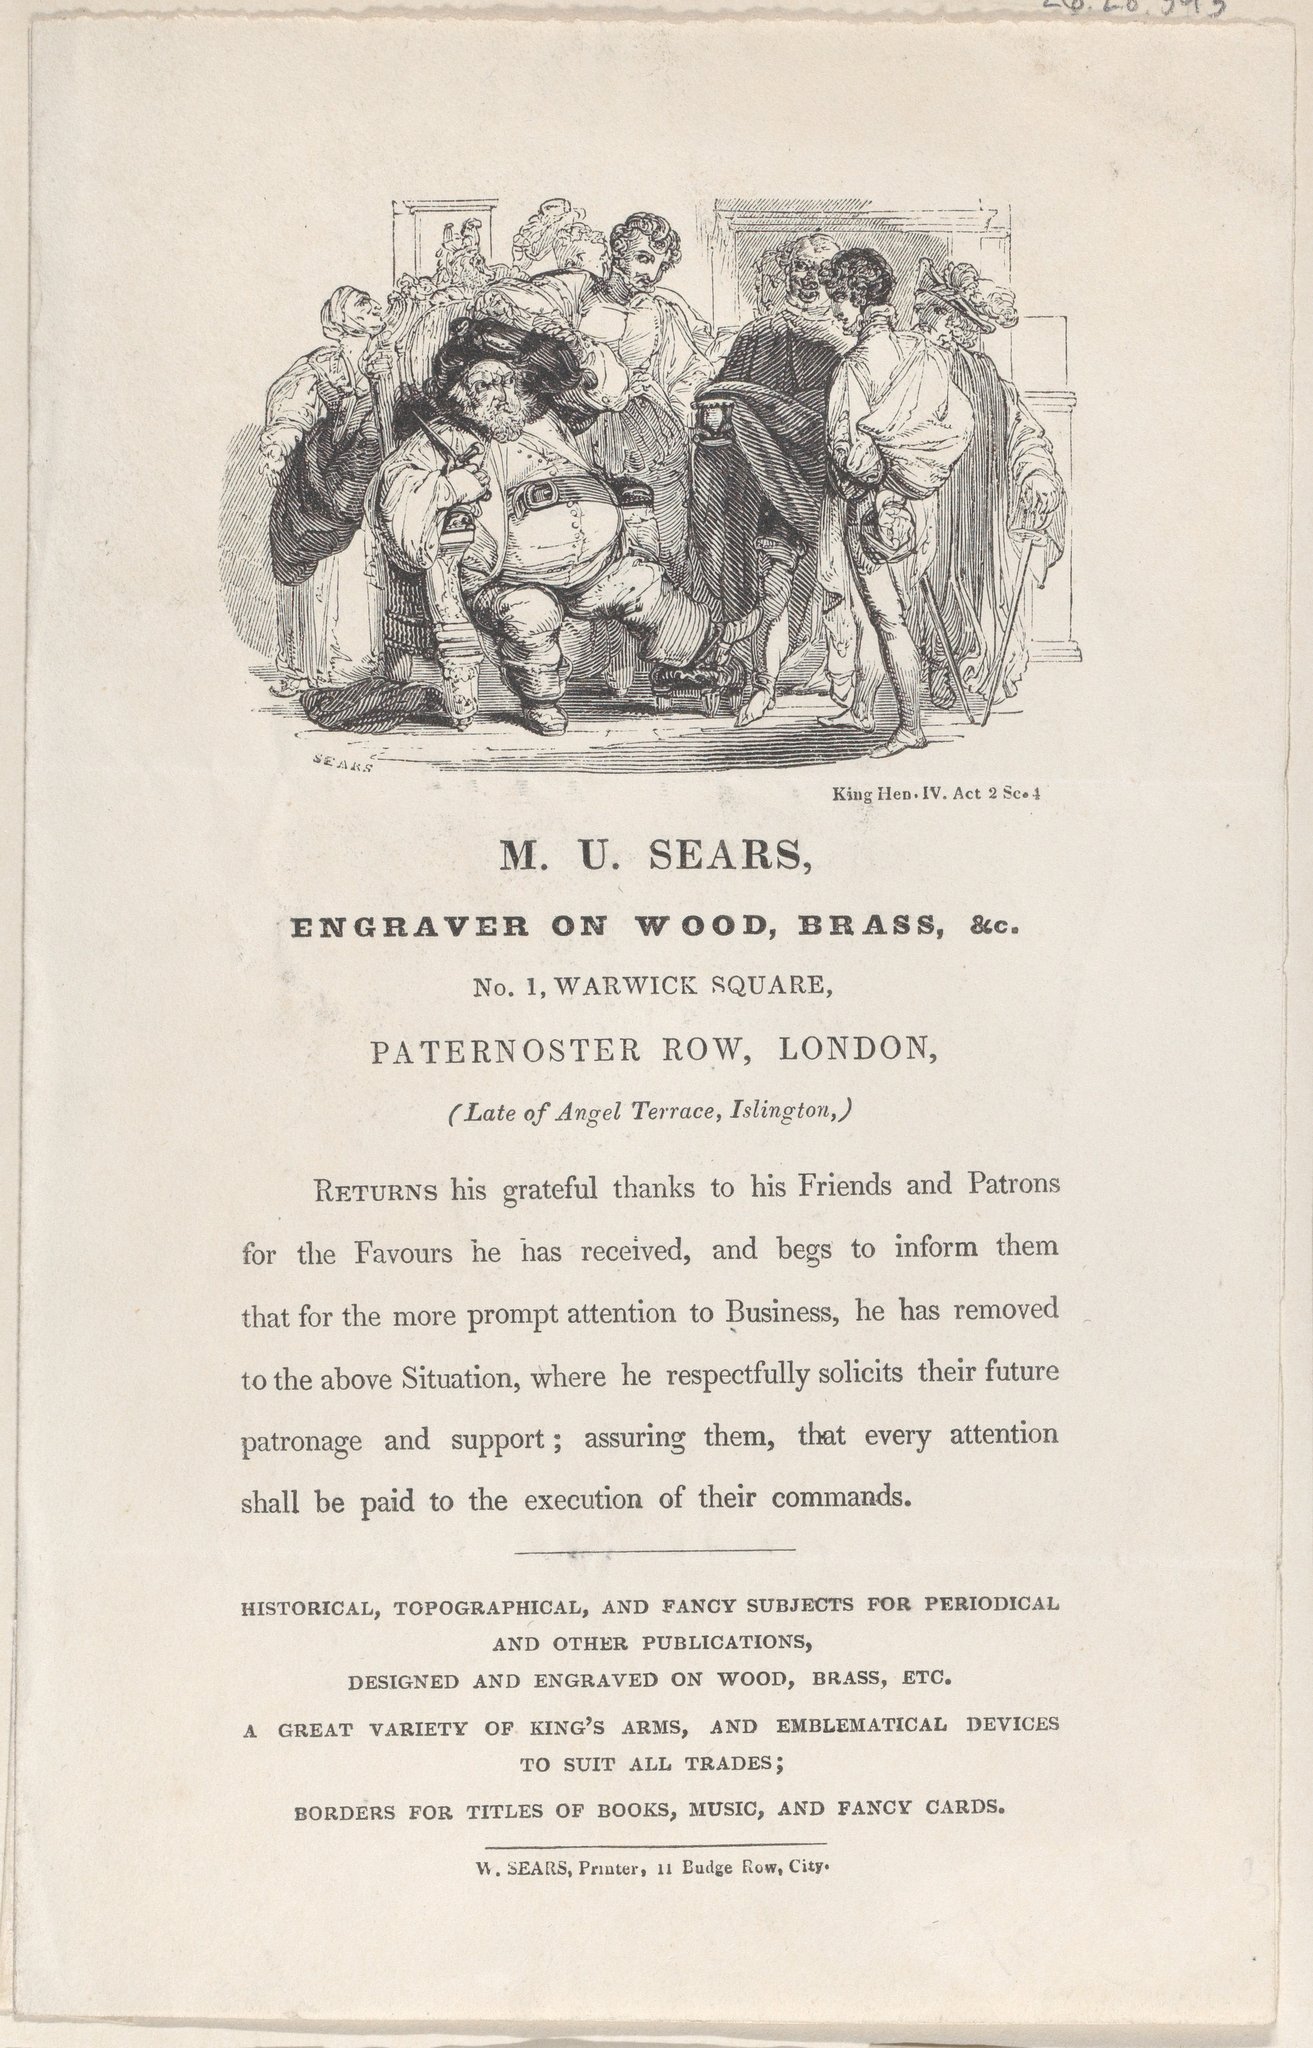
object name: print, trade card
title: Trade Card for M.U. Sears, Wood Engraver and Printer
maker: matthew urlwin sears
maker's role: engraver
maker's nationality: british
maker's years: 1826-1859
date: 1826-1859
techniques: engraving